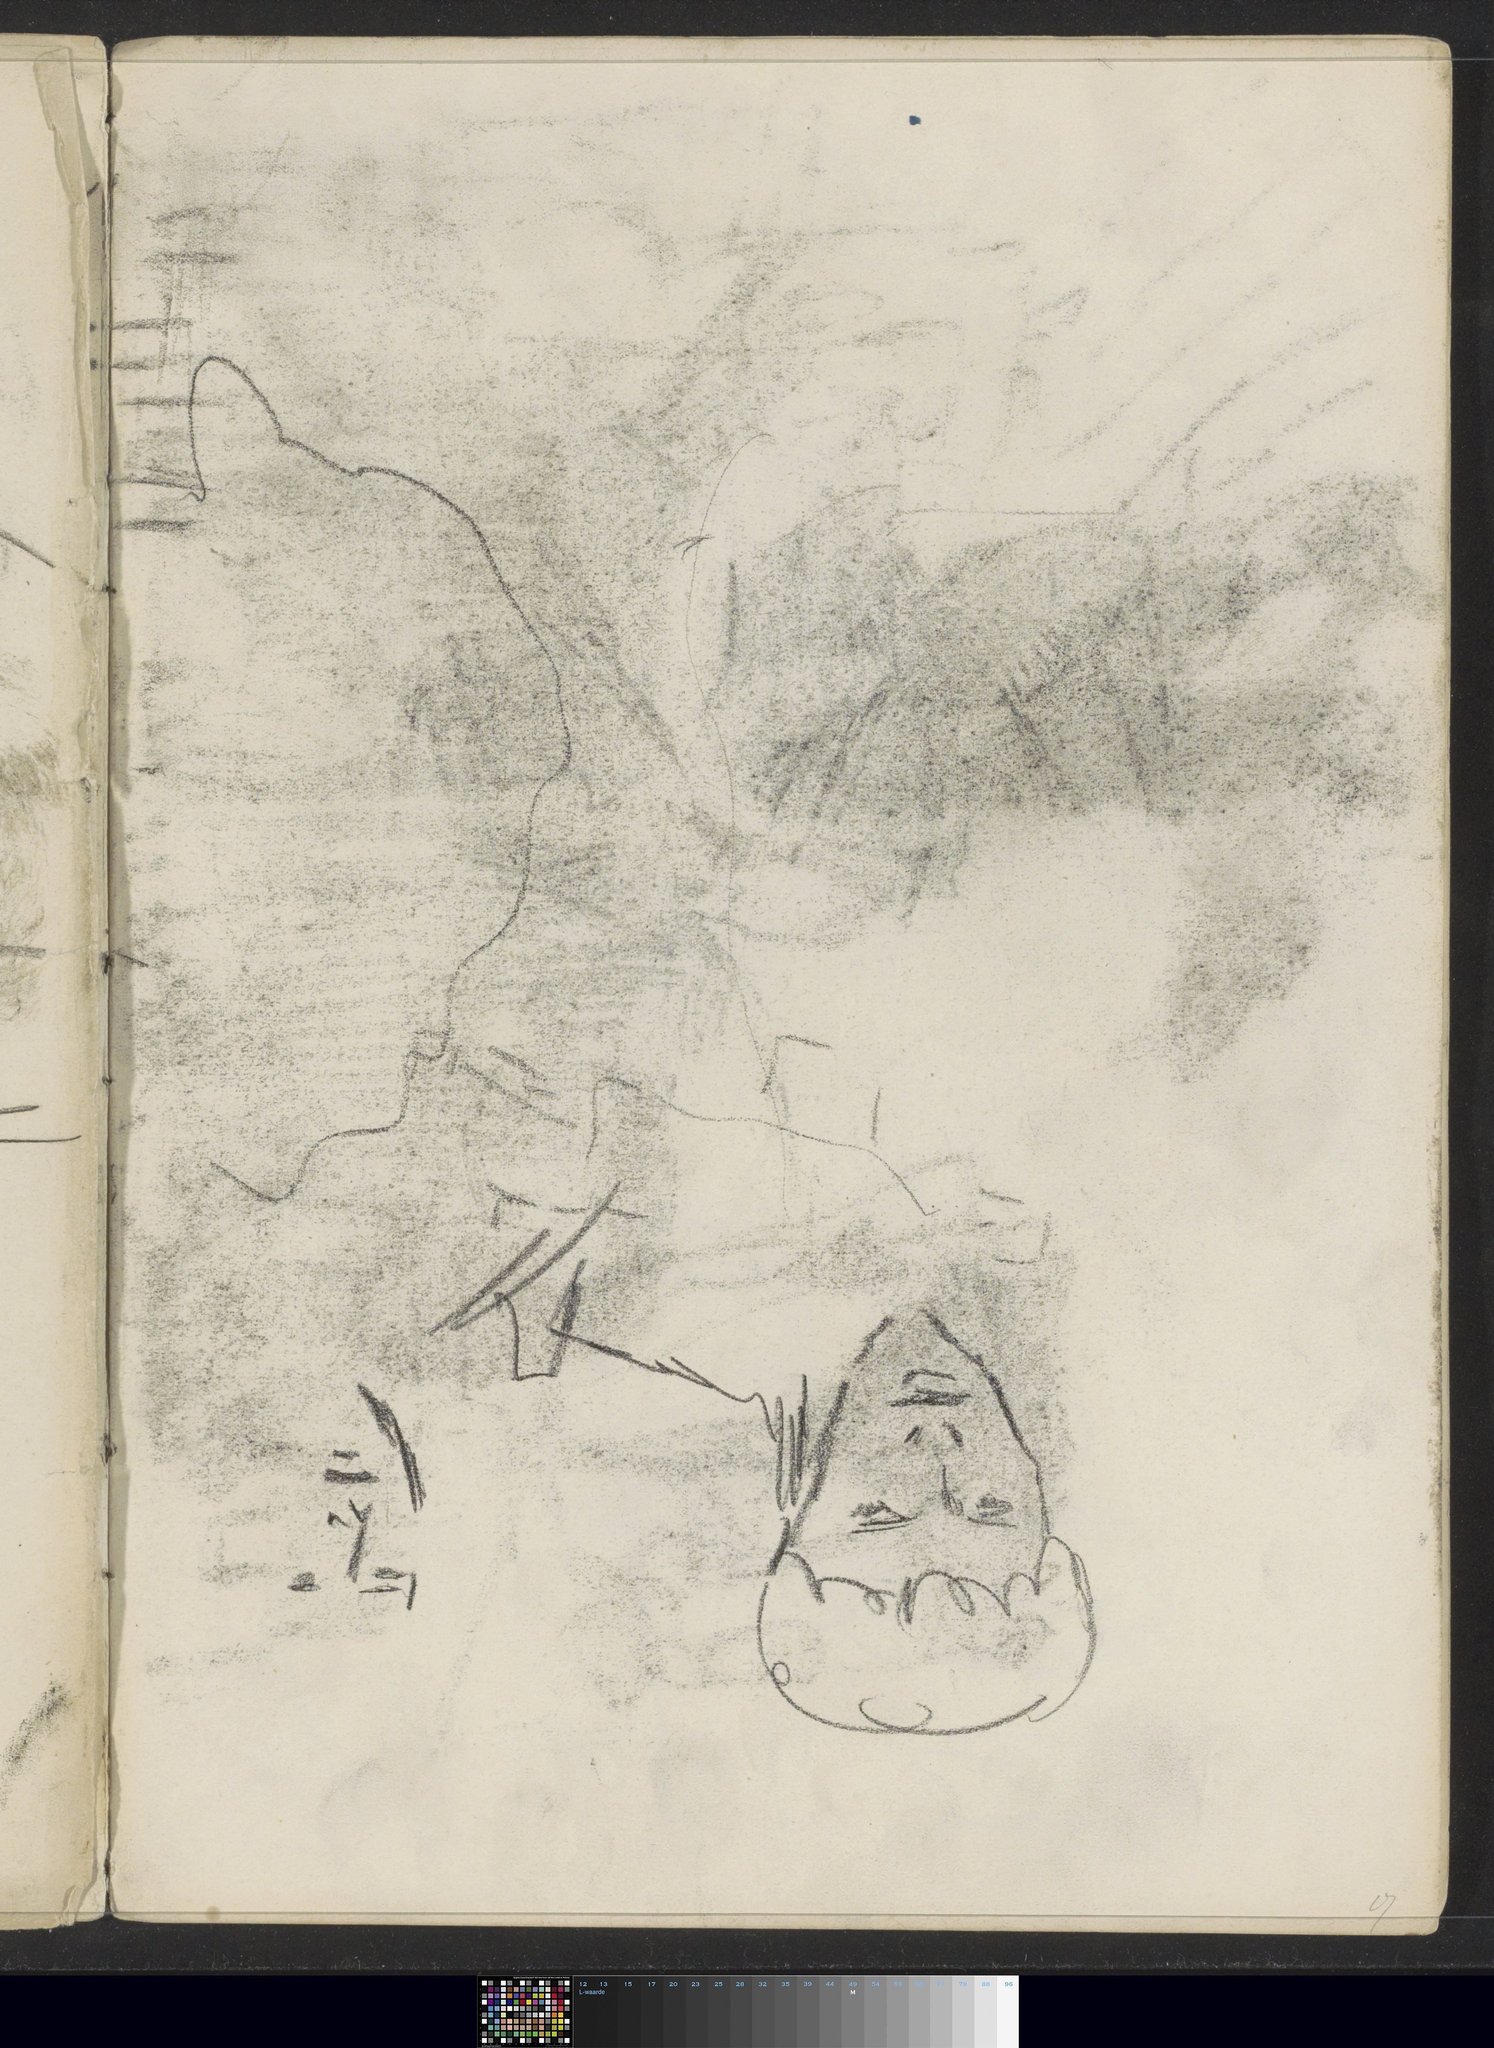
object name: sketchbook leaf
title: Twee vrouwenhoofden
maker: isaac israels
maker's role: draughtsman, painter, print maker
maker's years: 1865-1934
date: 1886-1934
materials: chalk, paper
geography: amsterdam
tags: head (human) - aa - female human figure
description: Blad 17 recto uit schetsboek LXVI-B met 25 bladen.